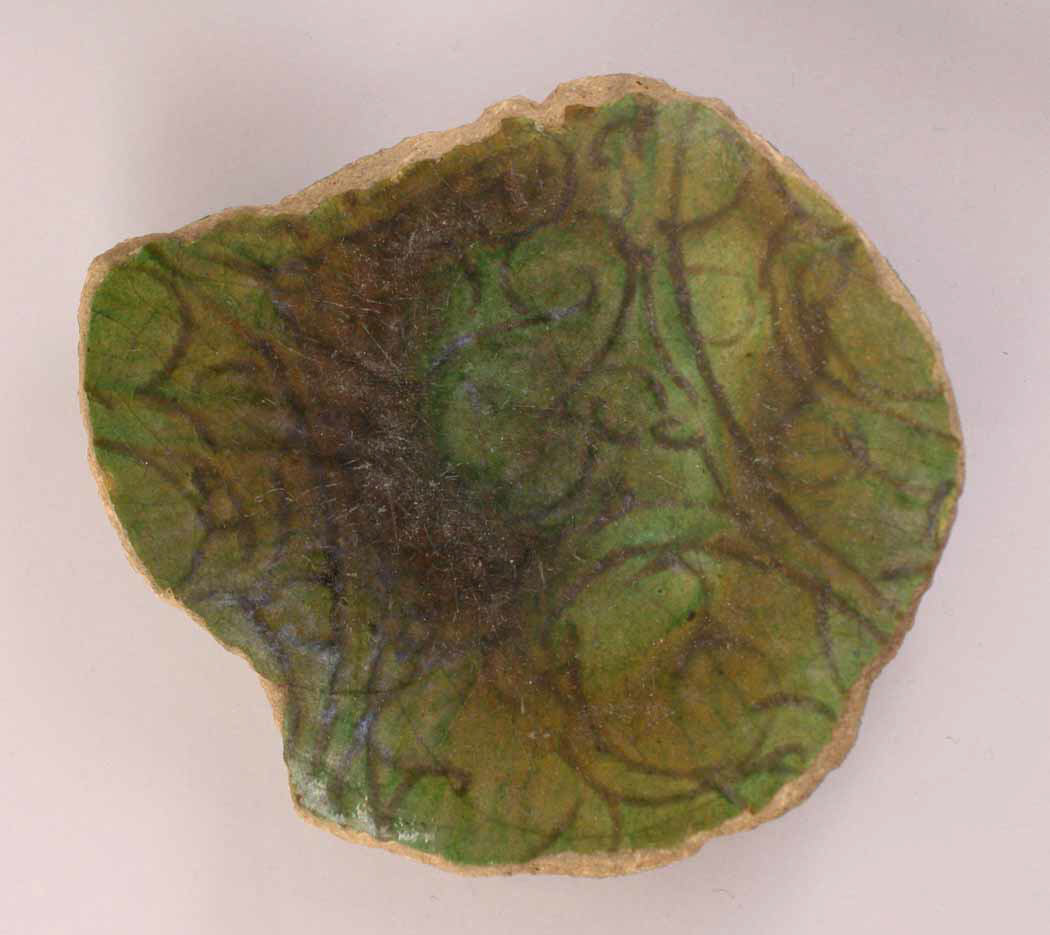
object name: ceramic fragment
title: Fragment of a Dish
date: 1201-1400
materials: earthenware, glaze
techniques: incising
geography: egypt